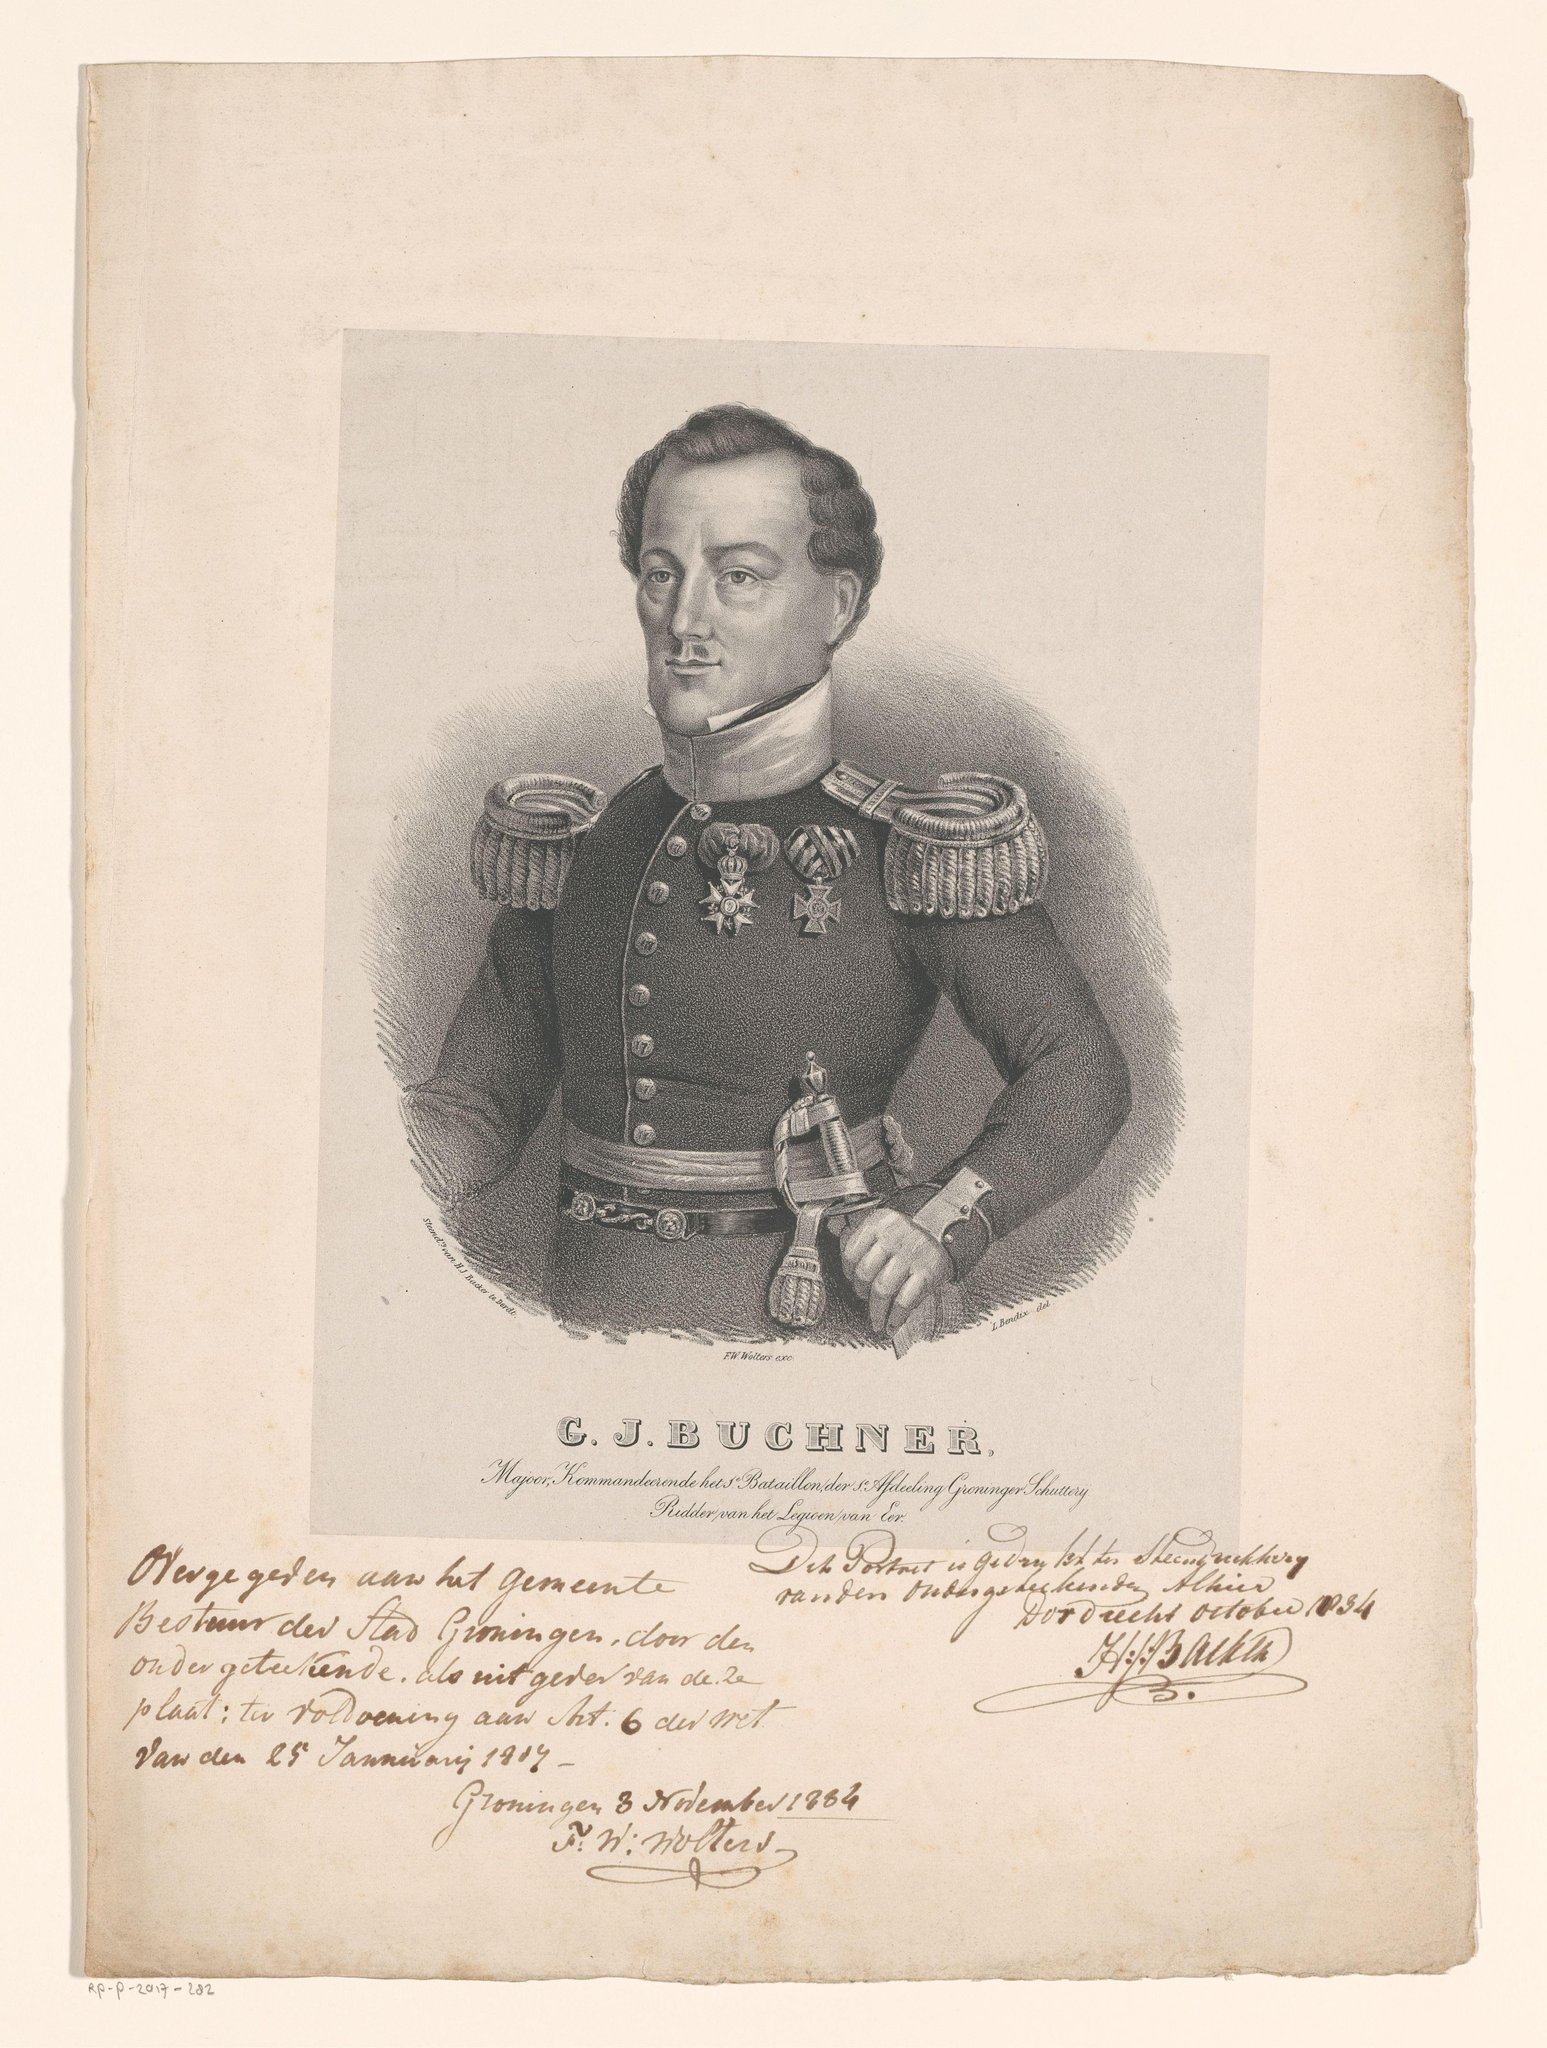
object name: print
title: Portret van majoor G.J. Buchner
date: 1834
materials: paper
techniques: lithograph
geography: groningen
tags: historical persons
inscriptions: : ‘Dit portret is gedrukt ter steendrukkerij / van den ondergeteekenden alhier / Dordrecht october 1834 / H:J: Backer’, : ‘Overgegeven aan het gemeente / bestuur der stad Groningen door den / ondergeteekende als uitgever van deze / plaat; ter voldoening aan Art: 6 der wet / van den 25 januari 1817 / Groningen 3 november 1834 / F:W:Wolters’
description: De geportretteerde draagt twee ridderorden op zijn borst. Hij draagt een sabel dat hij met zijn linkerhand vasthoudt.